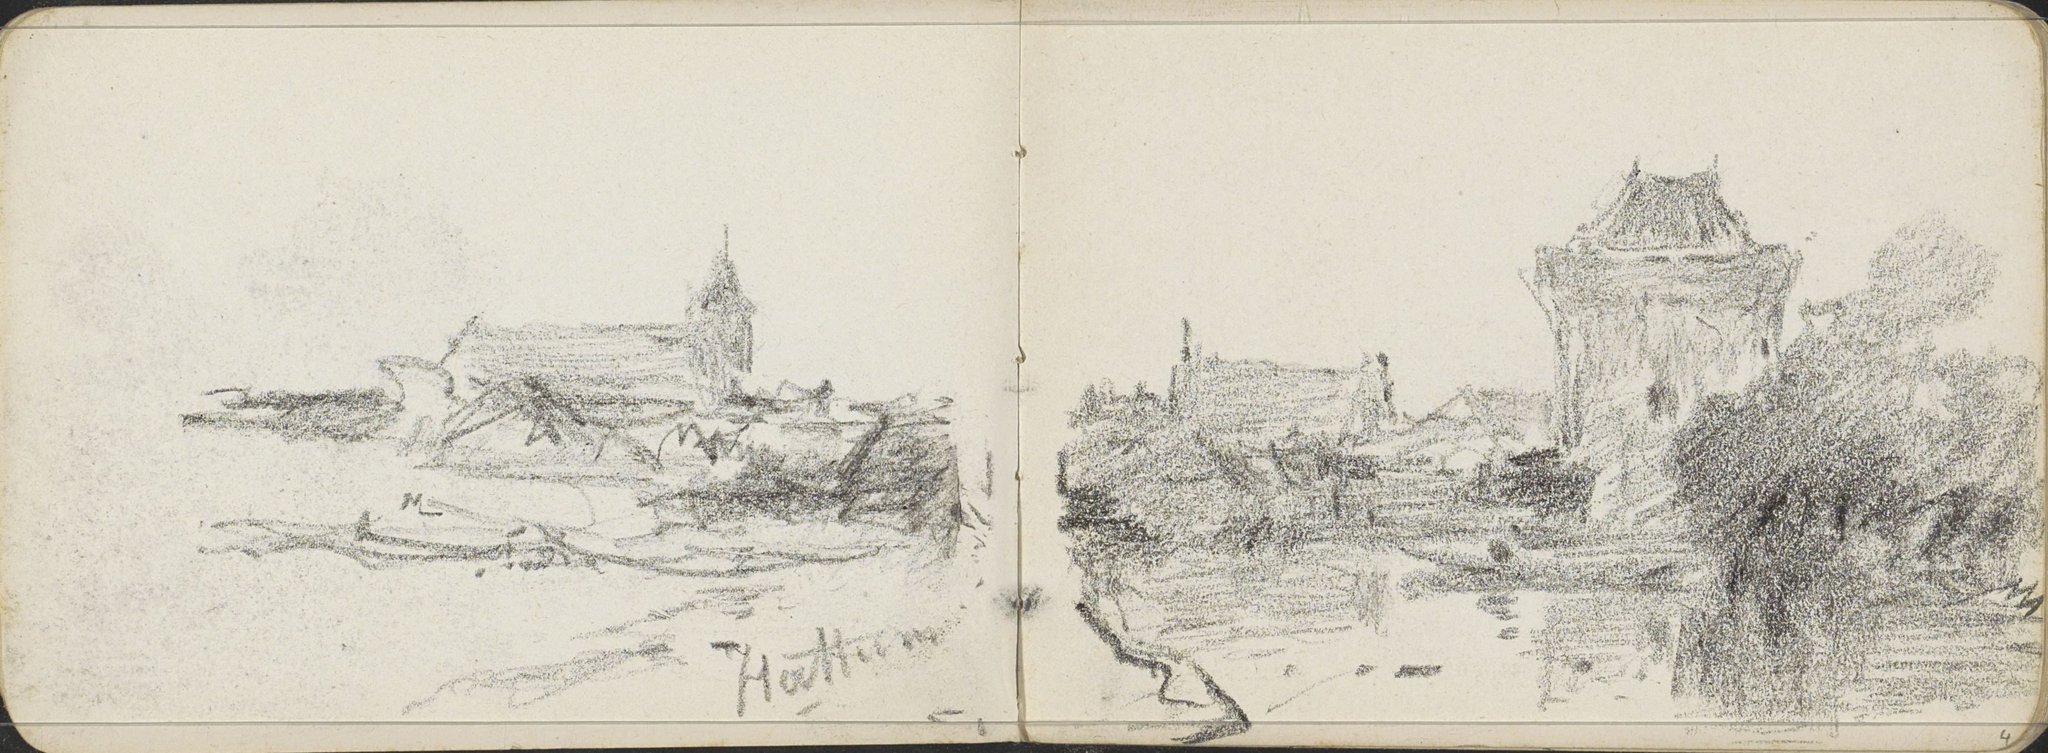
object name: sketchbook leaf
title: Gezicht op Hattem aan het water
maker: willem cornelis rip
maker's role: draughtsman, painter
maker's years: 1856-1922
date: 1907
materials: chalk, paper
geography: hattem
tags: city-view, and landscape with man-made constructions, landscapes with waters, waterscapes, seascapes (in the temperate zone)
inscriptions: annotation: ‘Hattum’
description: Blad 3 verso en 4 recto uit een schetsboek met 41 bladen.